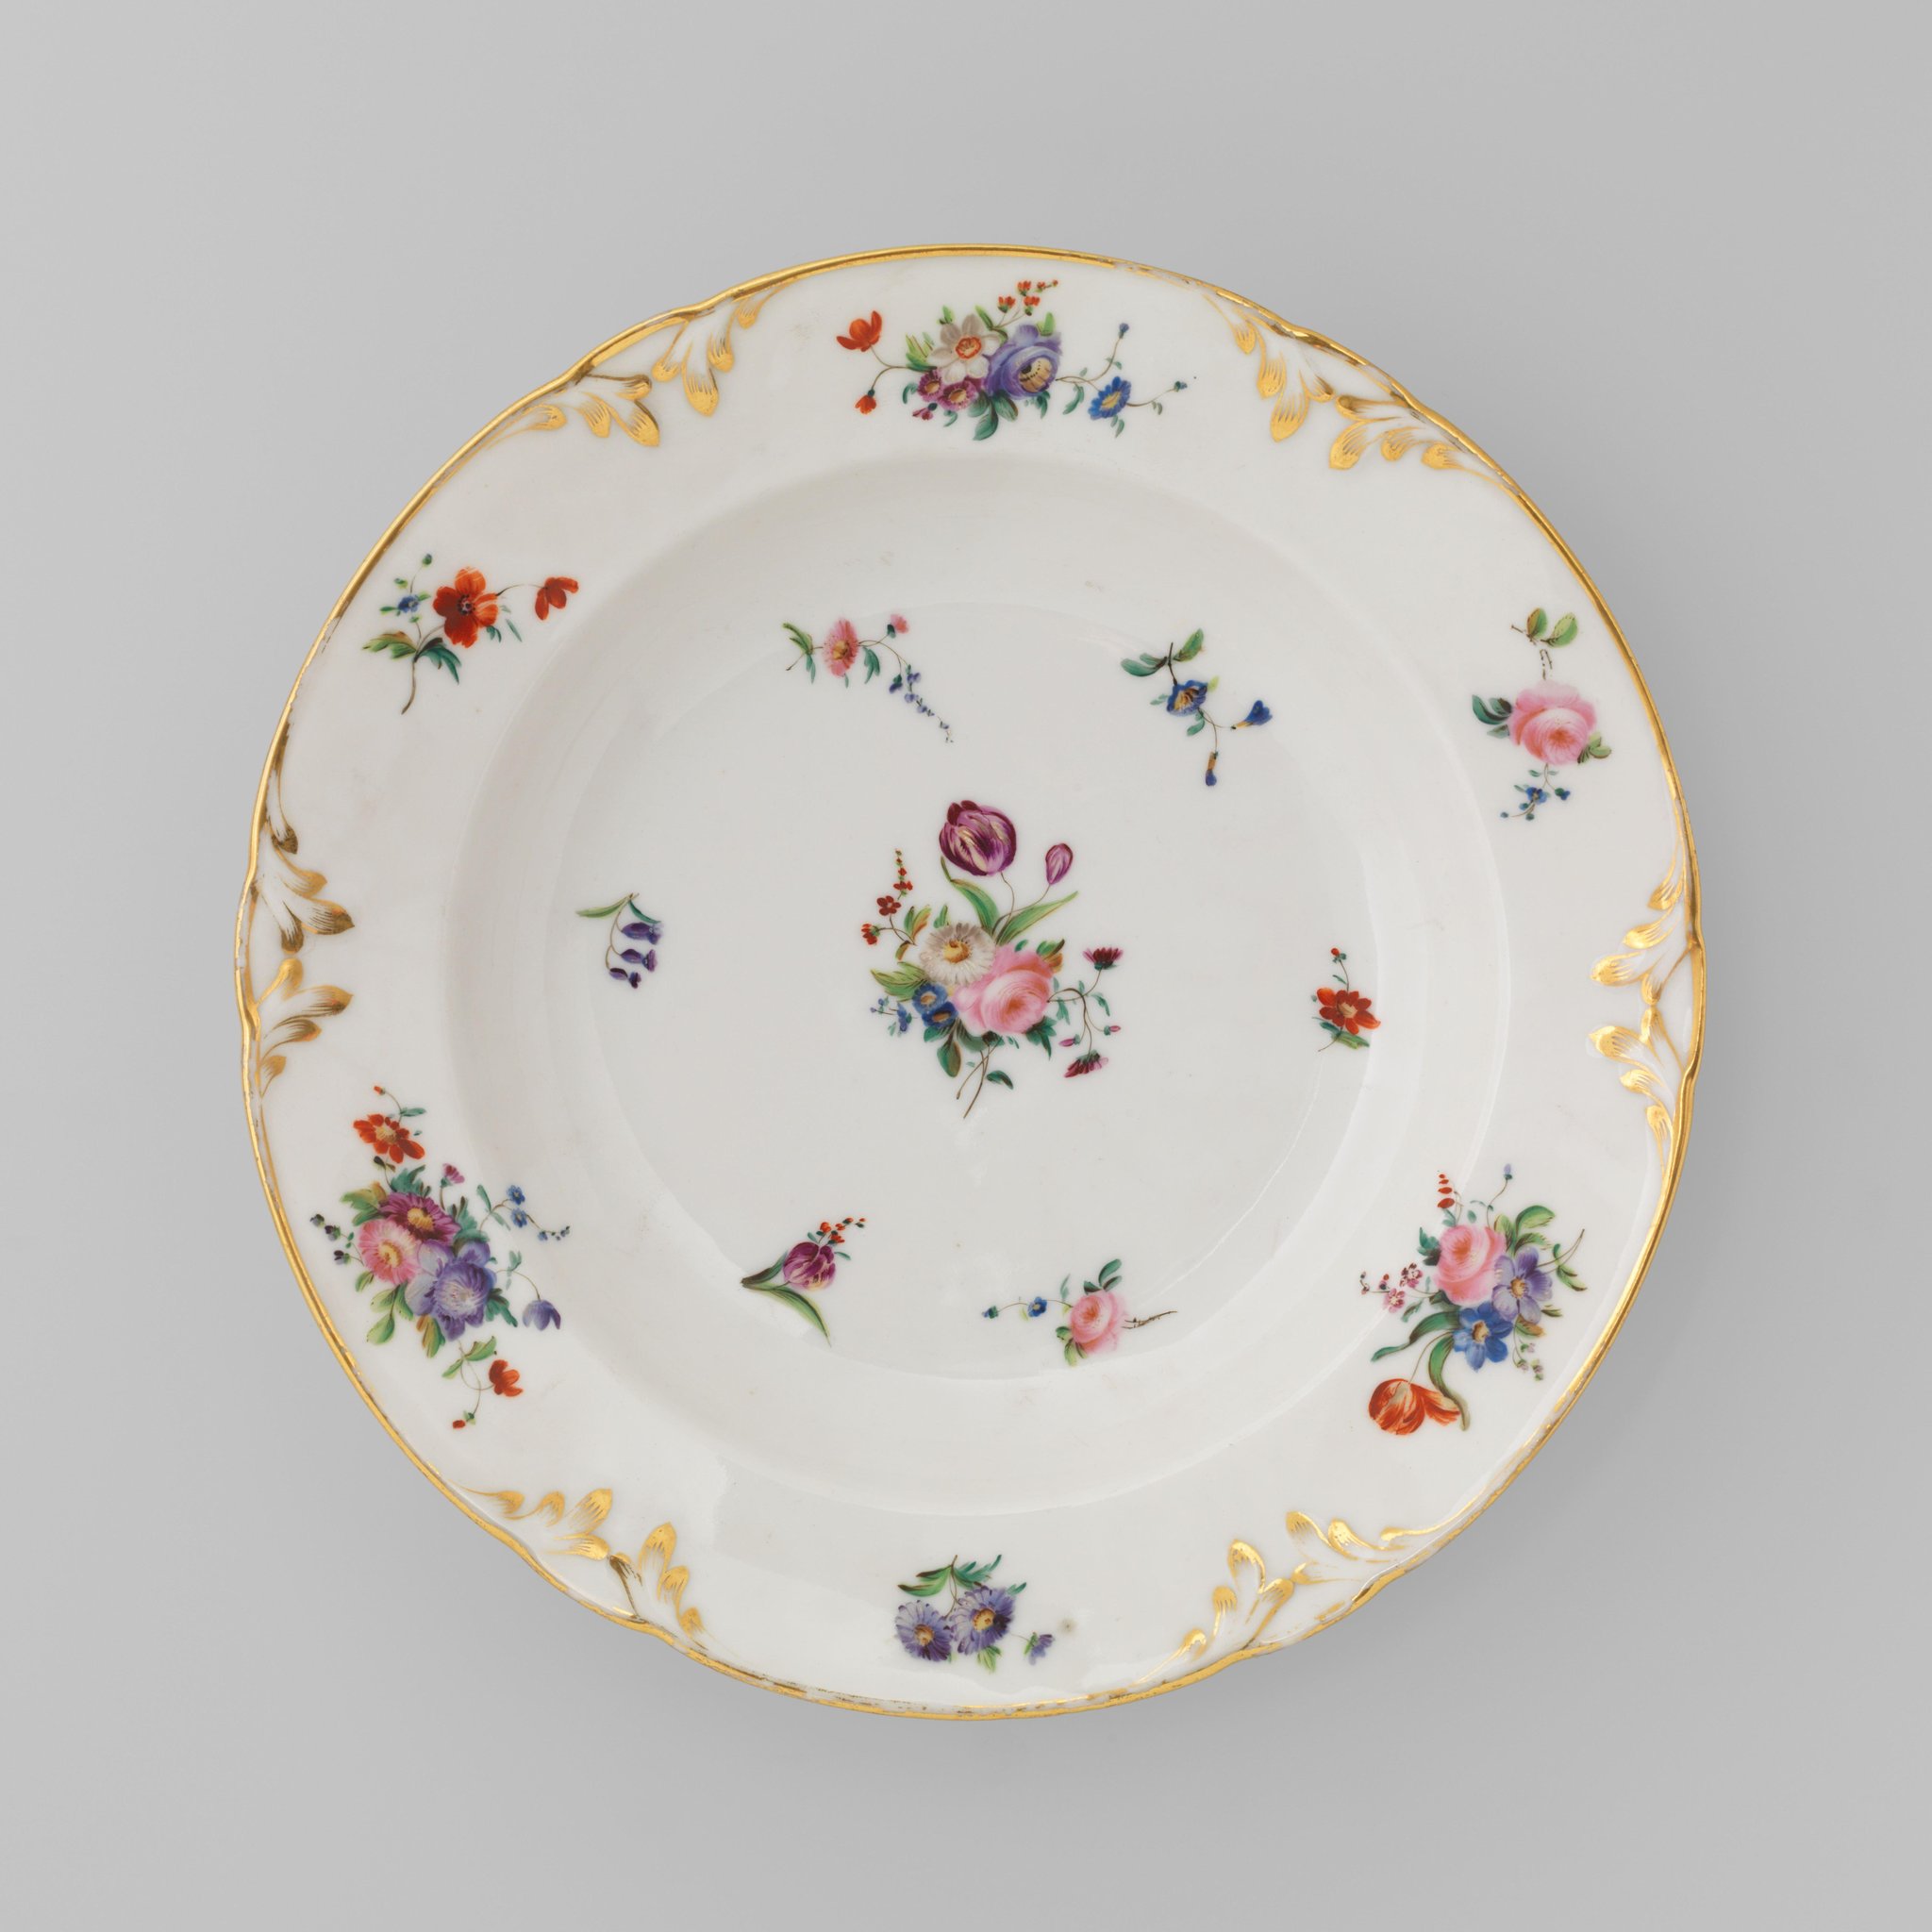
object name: service set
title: Plate with bouquets and flower sprays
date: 1839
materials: glaze, gold, paint, porcelain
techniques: firing, forming, gilding, turning, vitrification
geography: paris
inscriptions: mark: ‘DENUELLE/ Boulevard St. Denis 18/ à Paris’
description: Diep bord van porselein met een gelobde rand, beschilderd op het glazuur in blauw, rood, roze, groen, geel, paars, zwart en goud. Op het plat boeketten van verschillende bloemen en strooibloemen. Vanuit de gelobde, gouden rand, gemodelleerde bladranken in reliëf, aangezet met goud. Hiertussen boeketten. Drie proenen op de onderzijde. Gemerkt op de onderzijde met 'DENUELLE/ Boulevard St. Denis 18/ à Paris'.